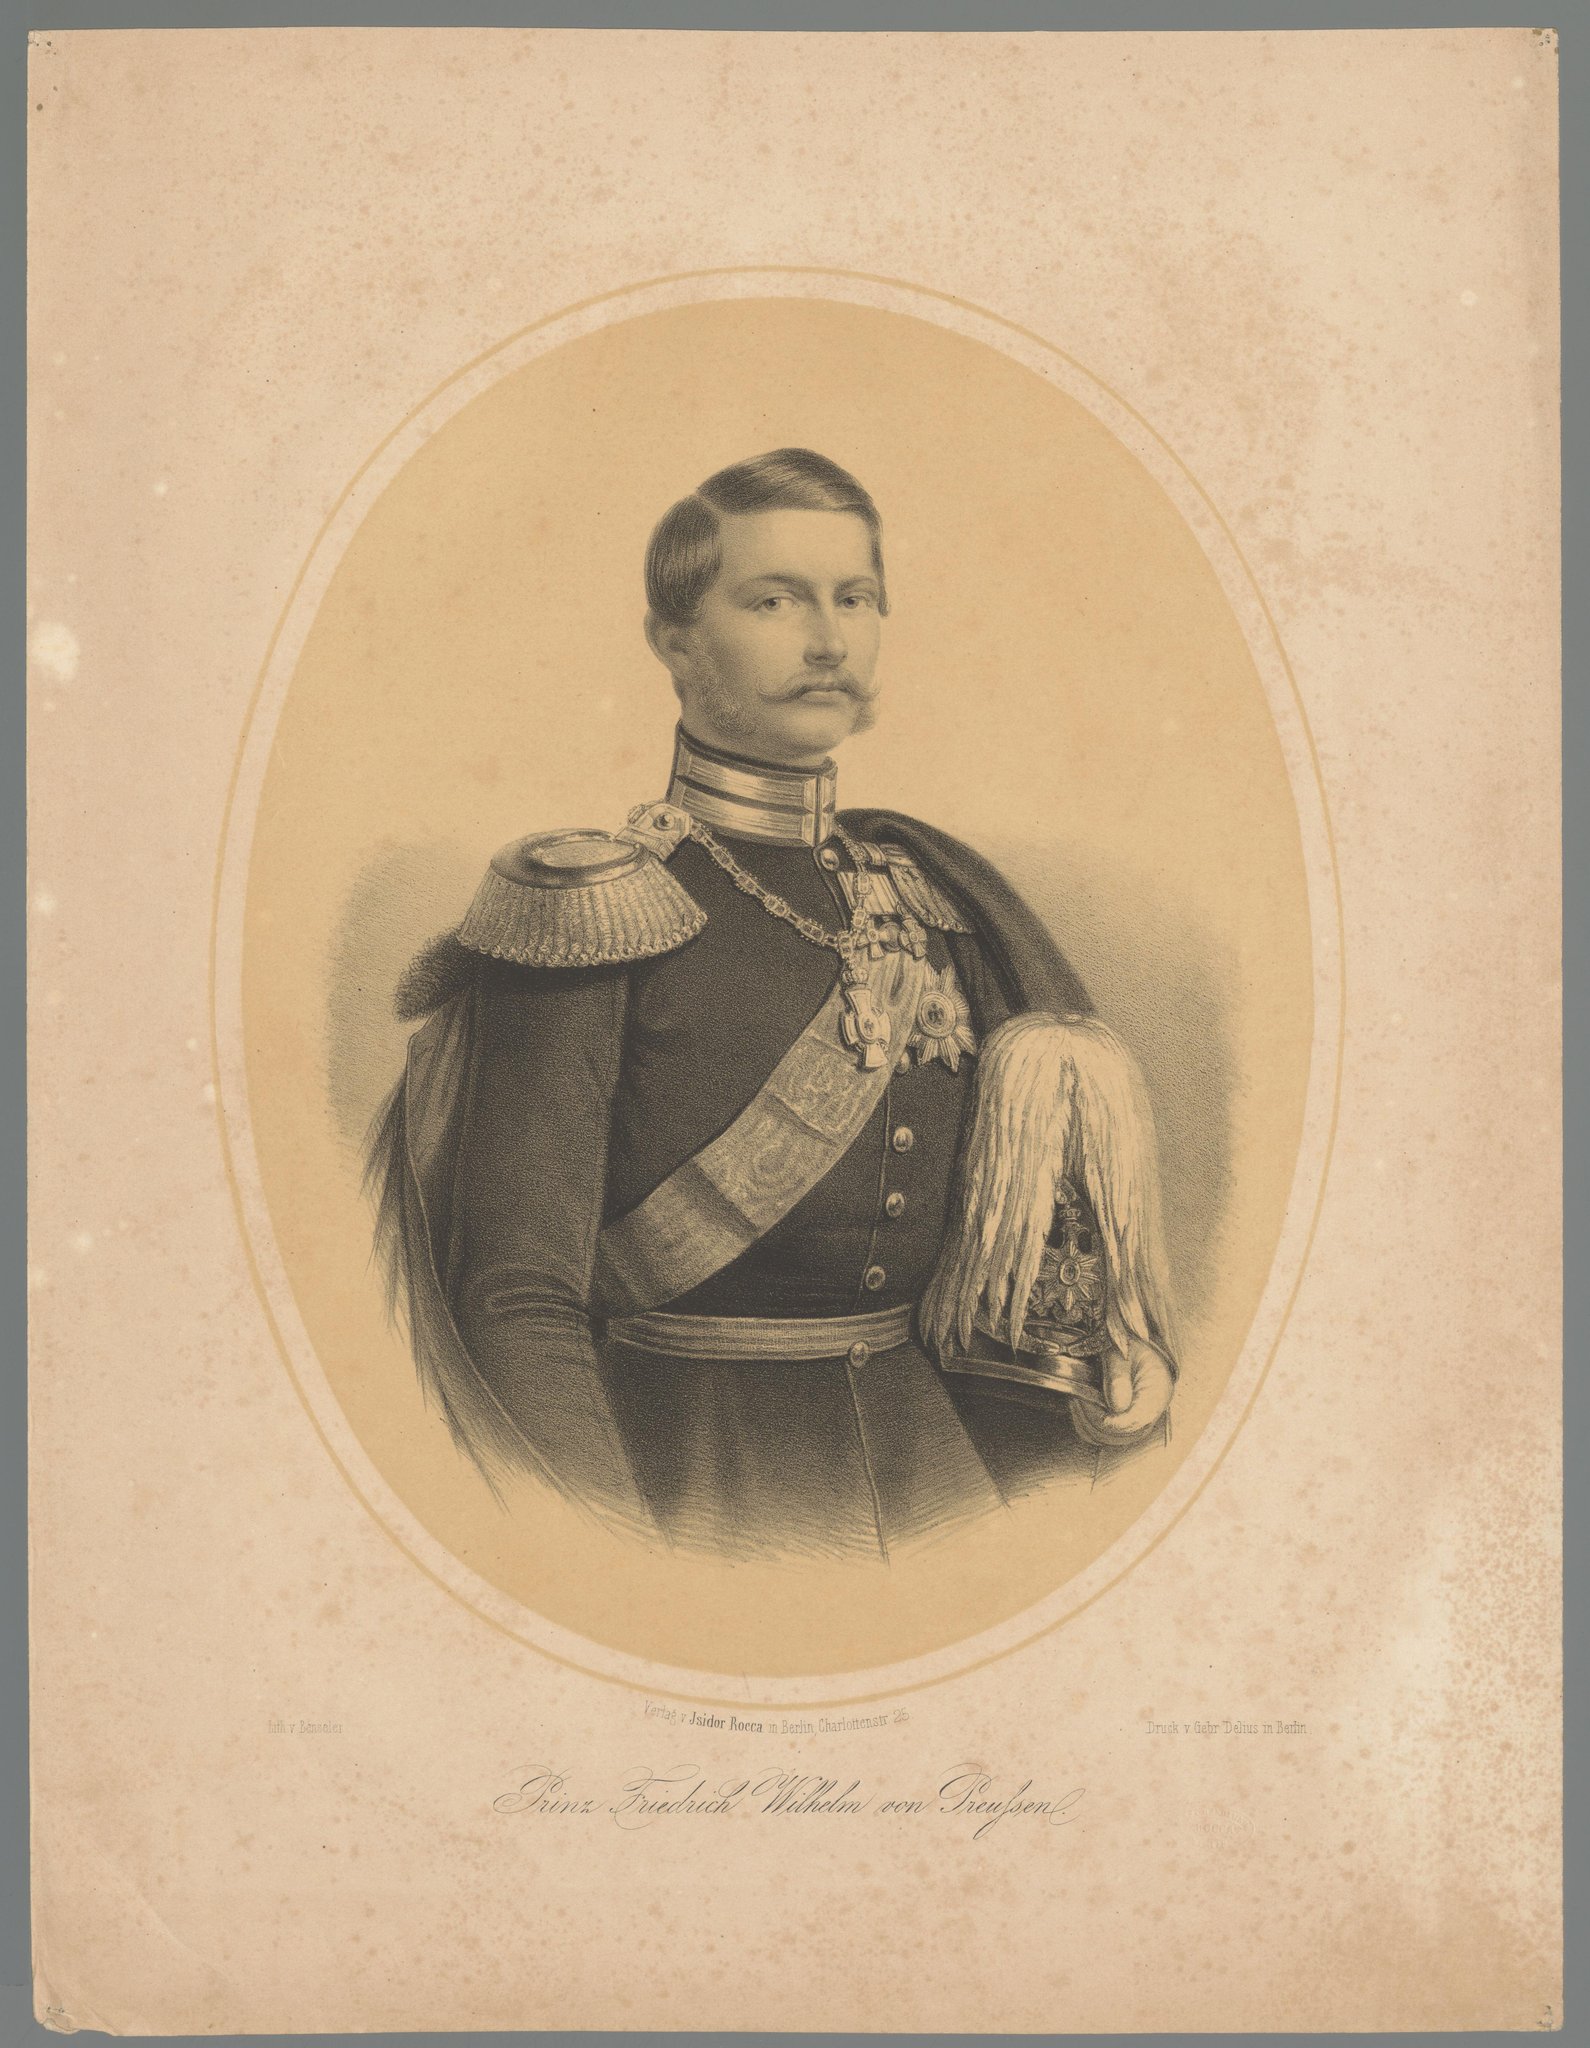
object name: print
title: Prinz Friedrich Wilhelm von Preussen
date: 1850-1899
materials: paper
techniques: tone lithography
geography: berlin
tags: moustache, adult man, historical persons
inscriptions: check stamp: ‘Kunsthandlung I. Rocca Berlin’, collector's mark: Lugt 2228